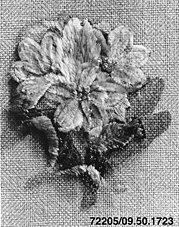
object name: ornament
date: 1801-1900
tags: flowers